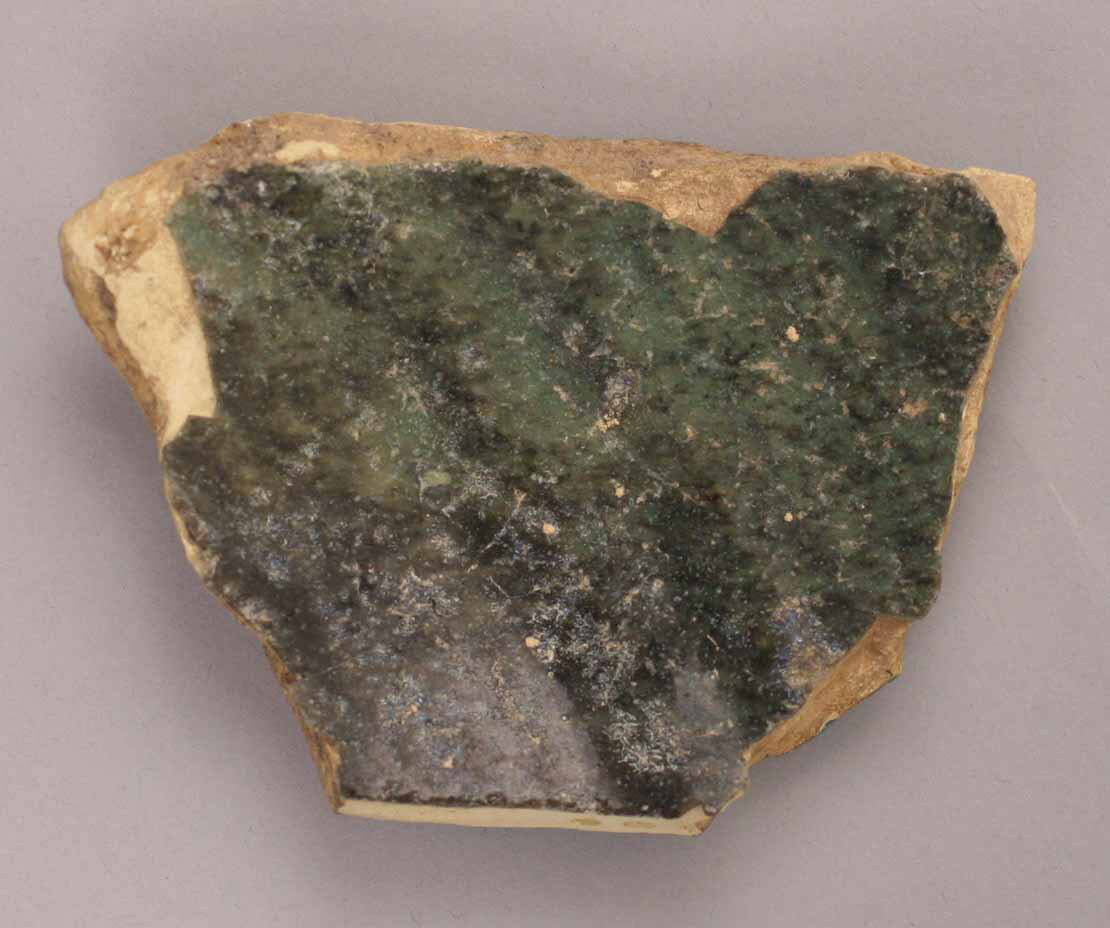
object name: fragment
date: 801-900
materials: earthenware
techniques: glazing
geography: iraq